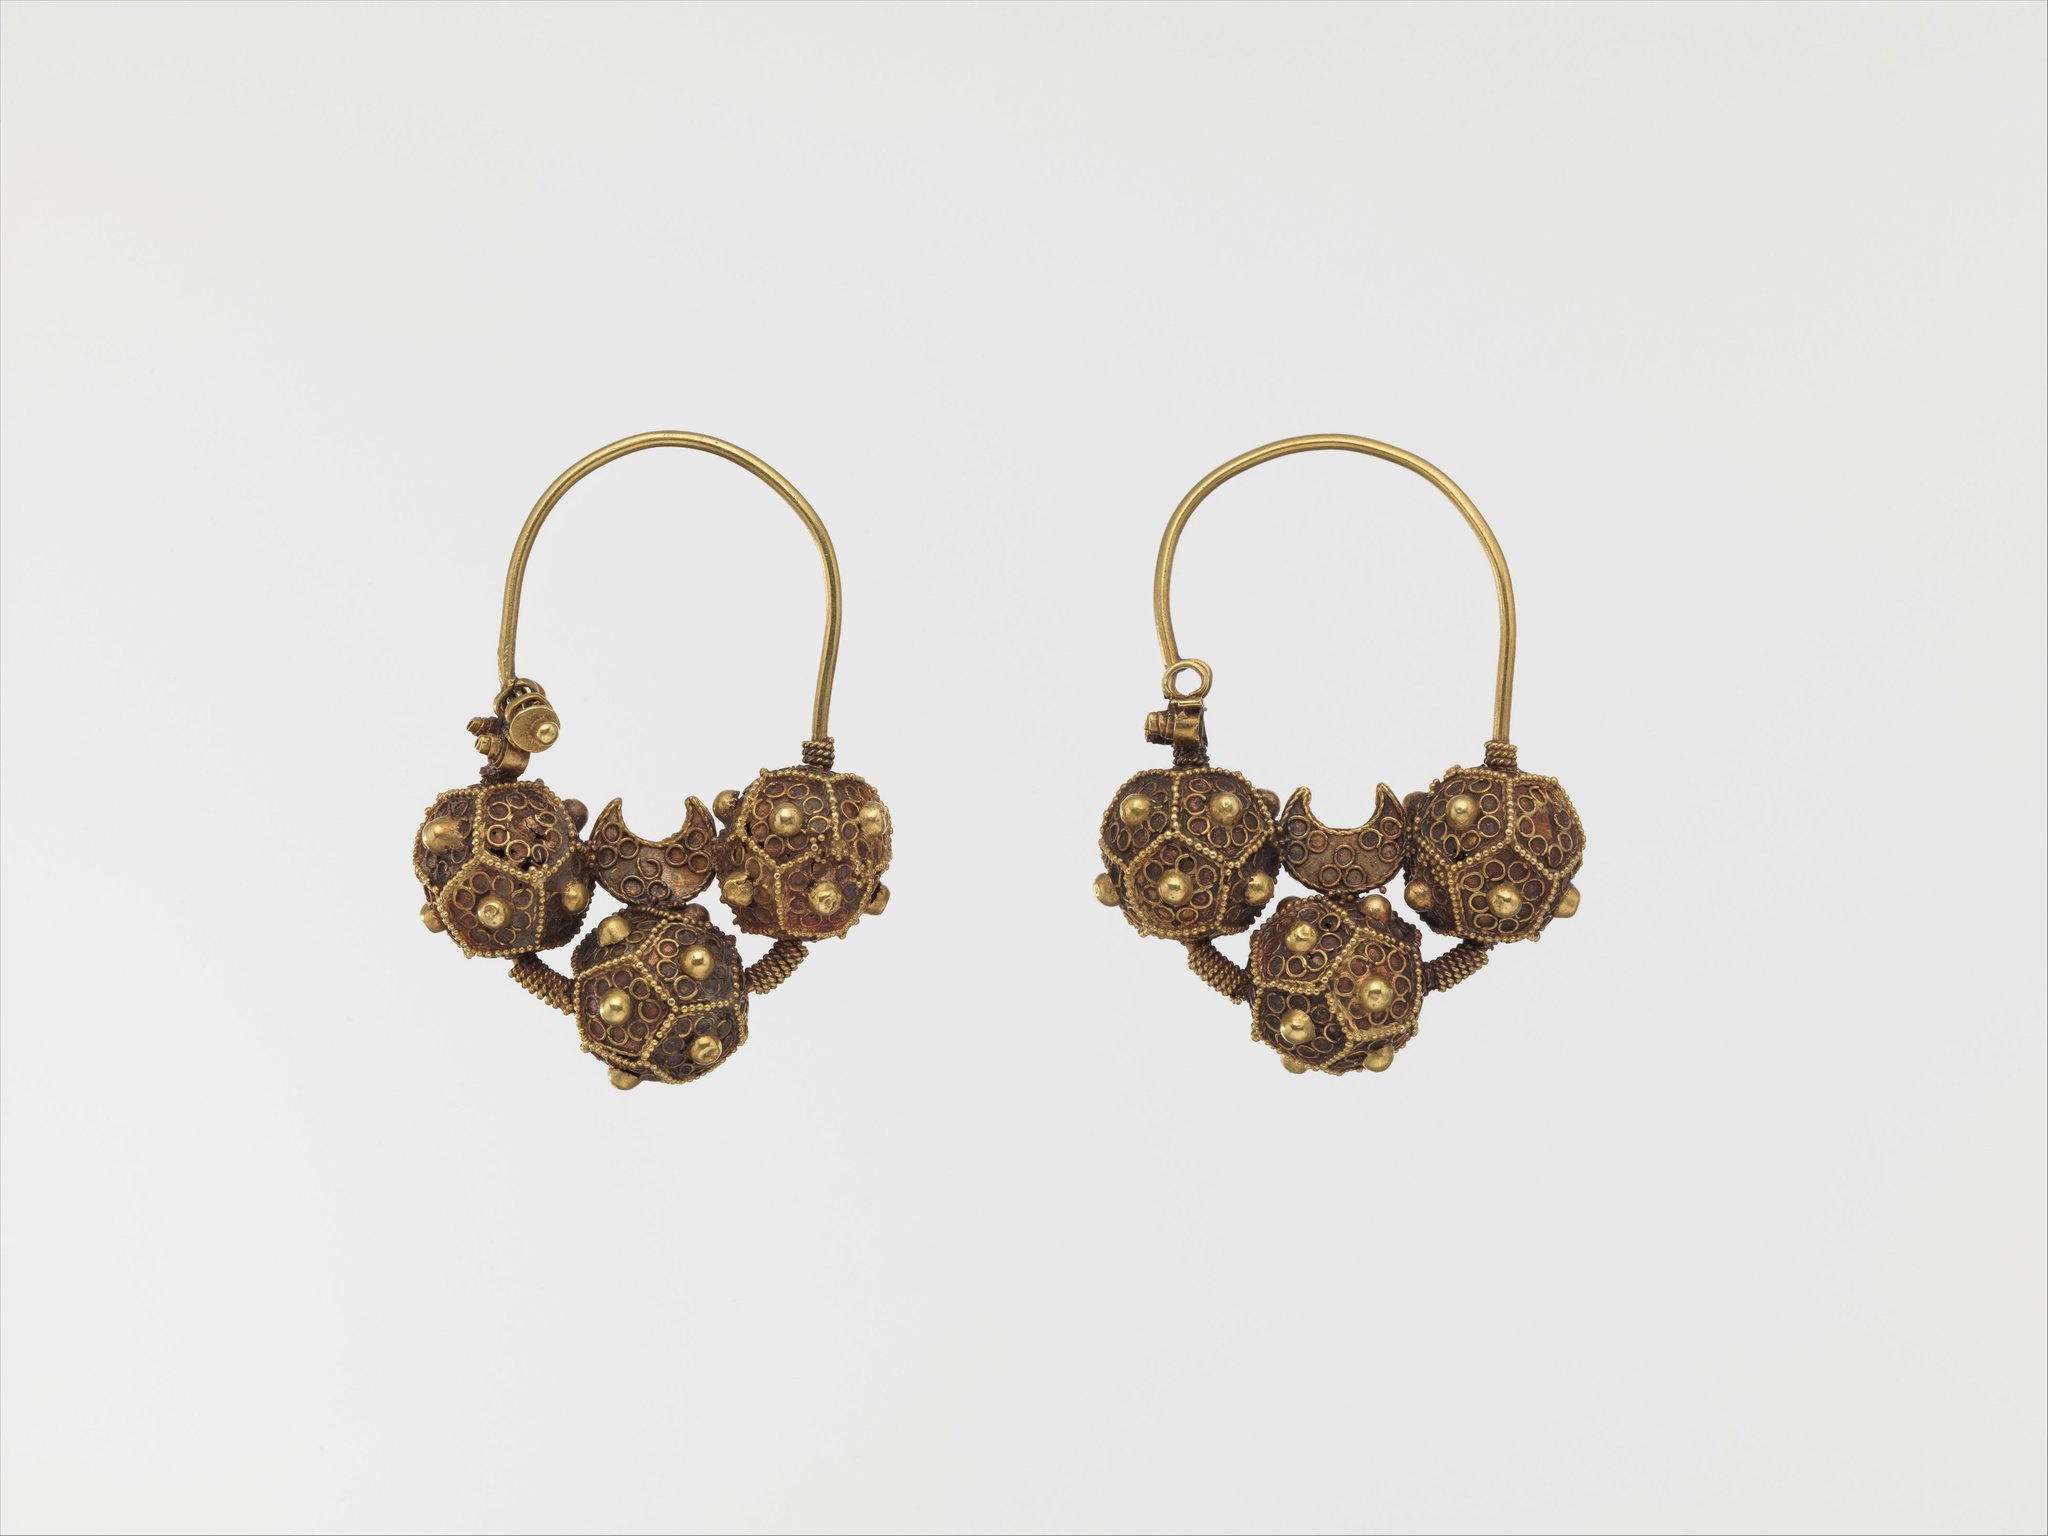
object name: earring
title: Earrings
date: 1001-1050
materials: gold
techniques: filigree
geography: iran